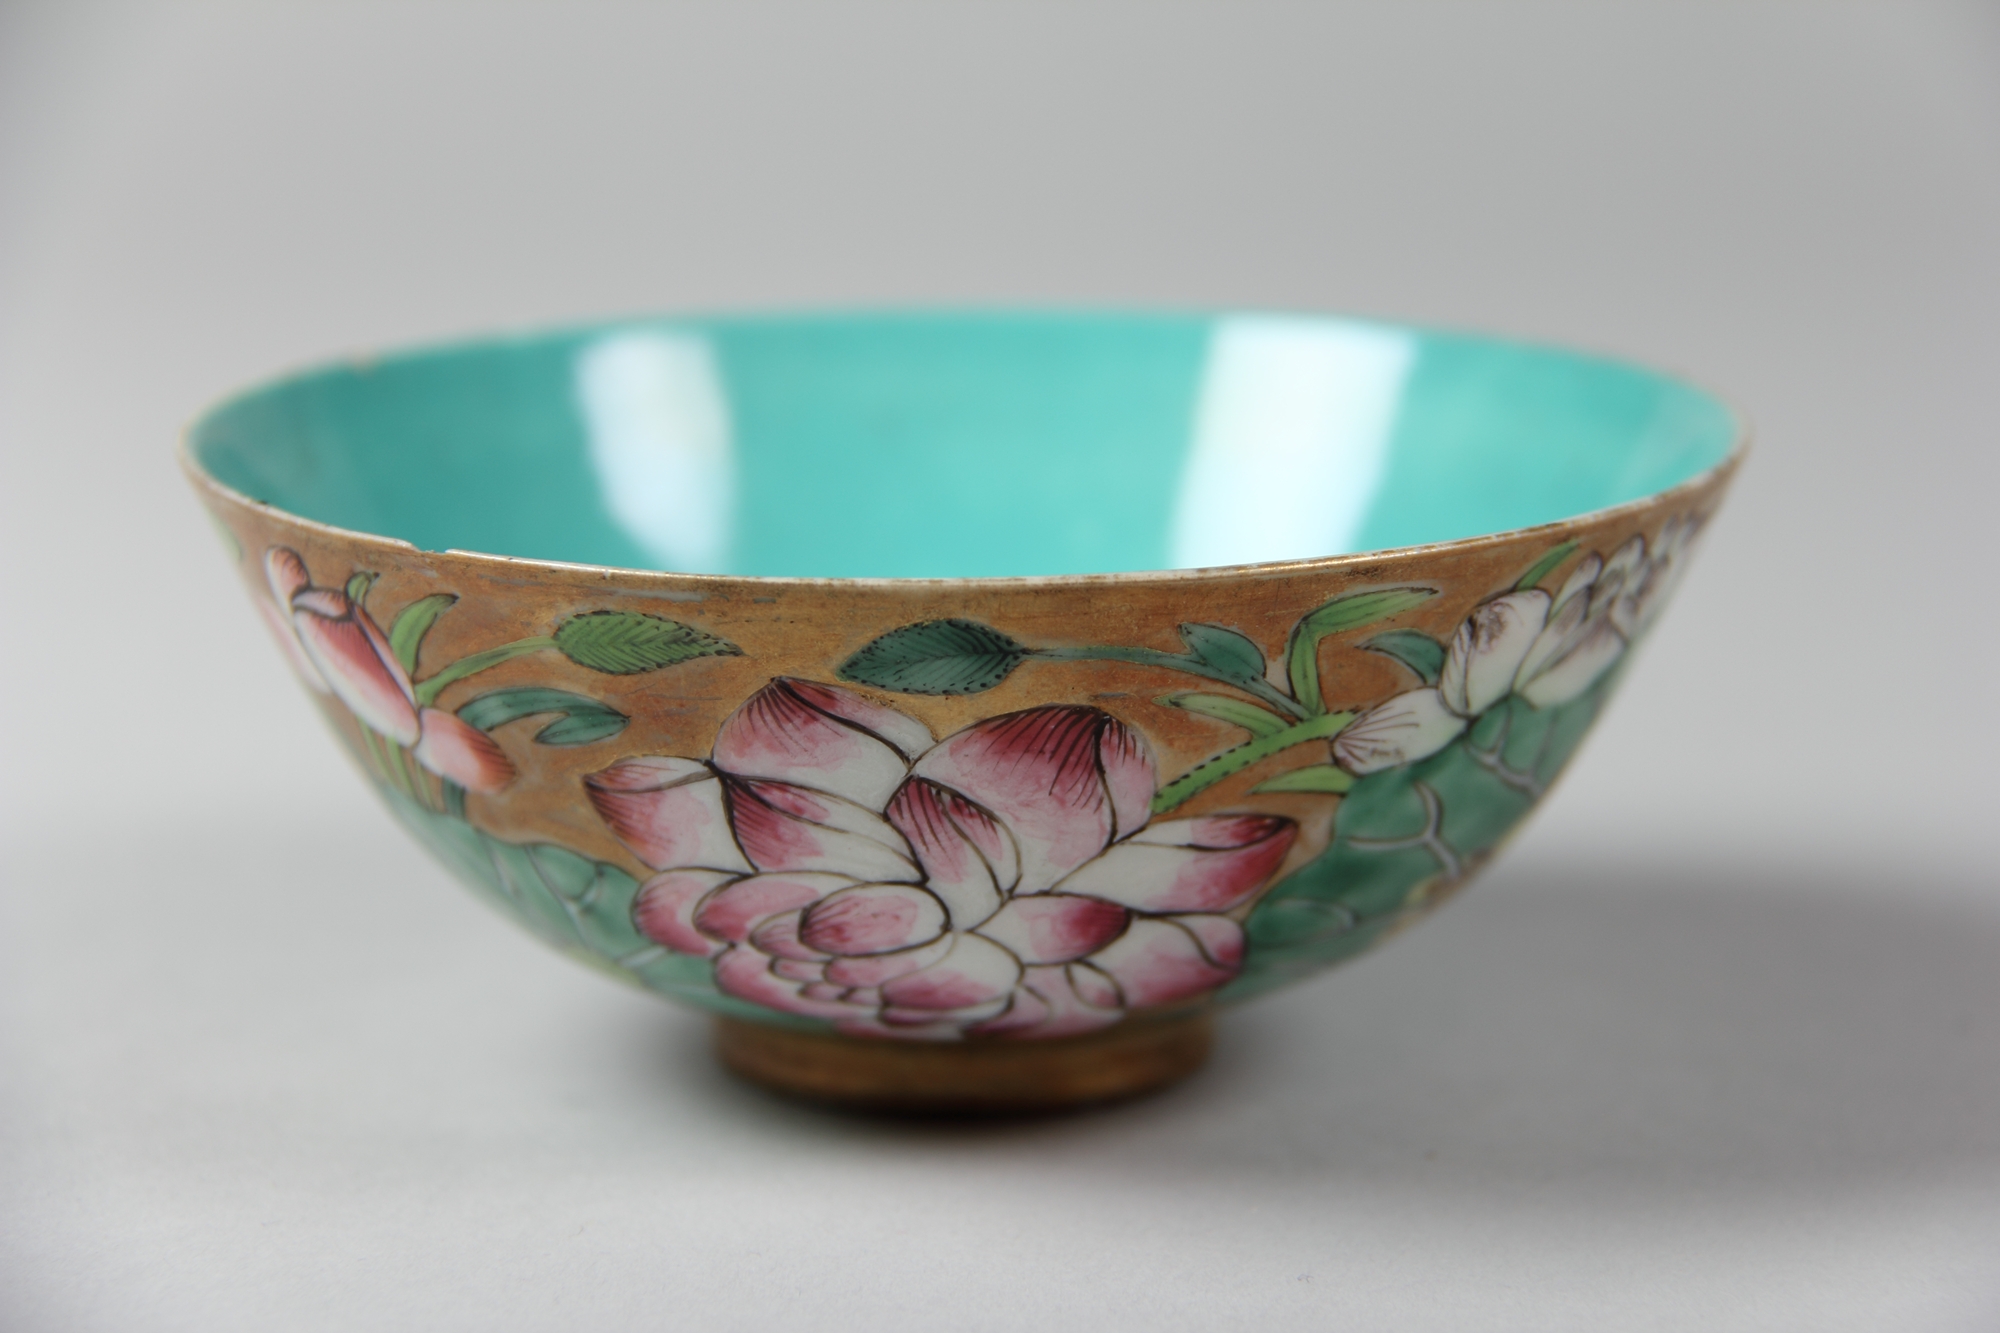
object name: cup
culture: chinese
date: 1862-1874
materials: enamel, gilt, glaze, porcelain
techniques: painting, polychrome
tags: flowers,leaves